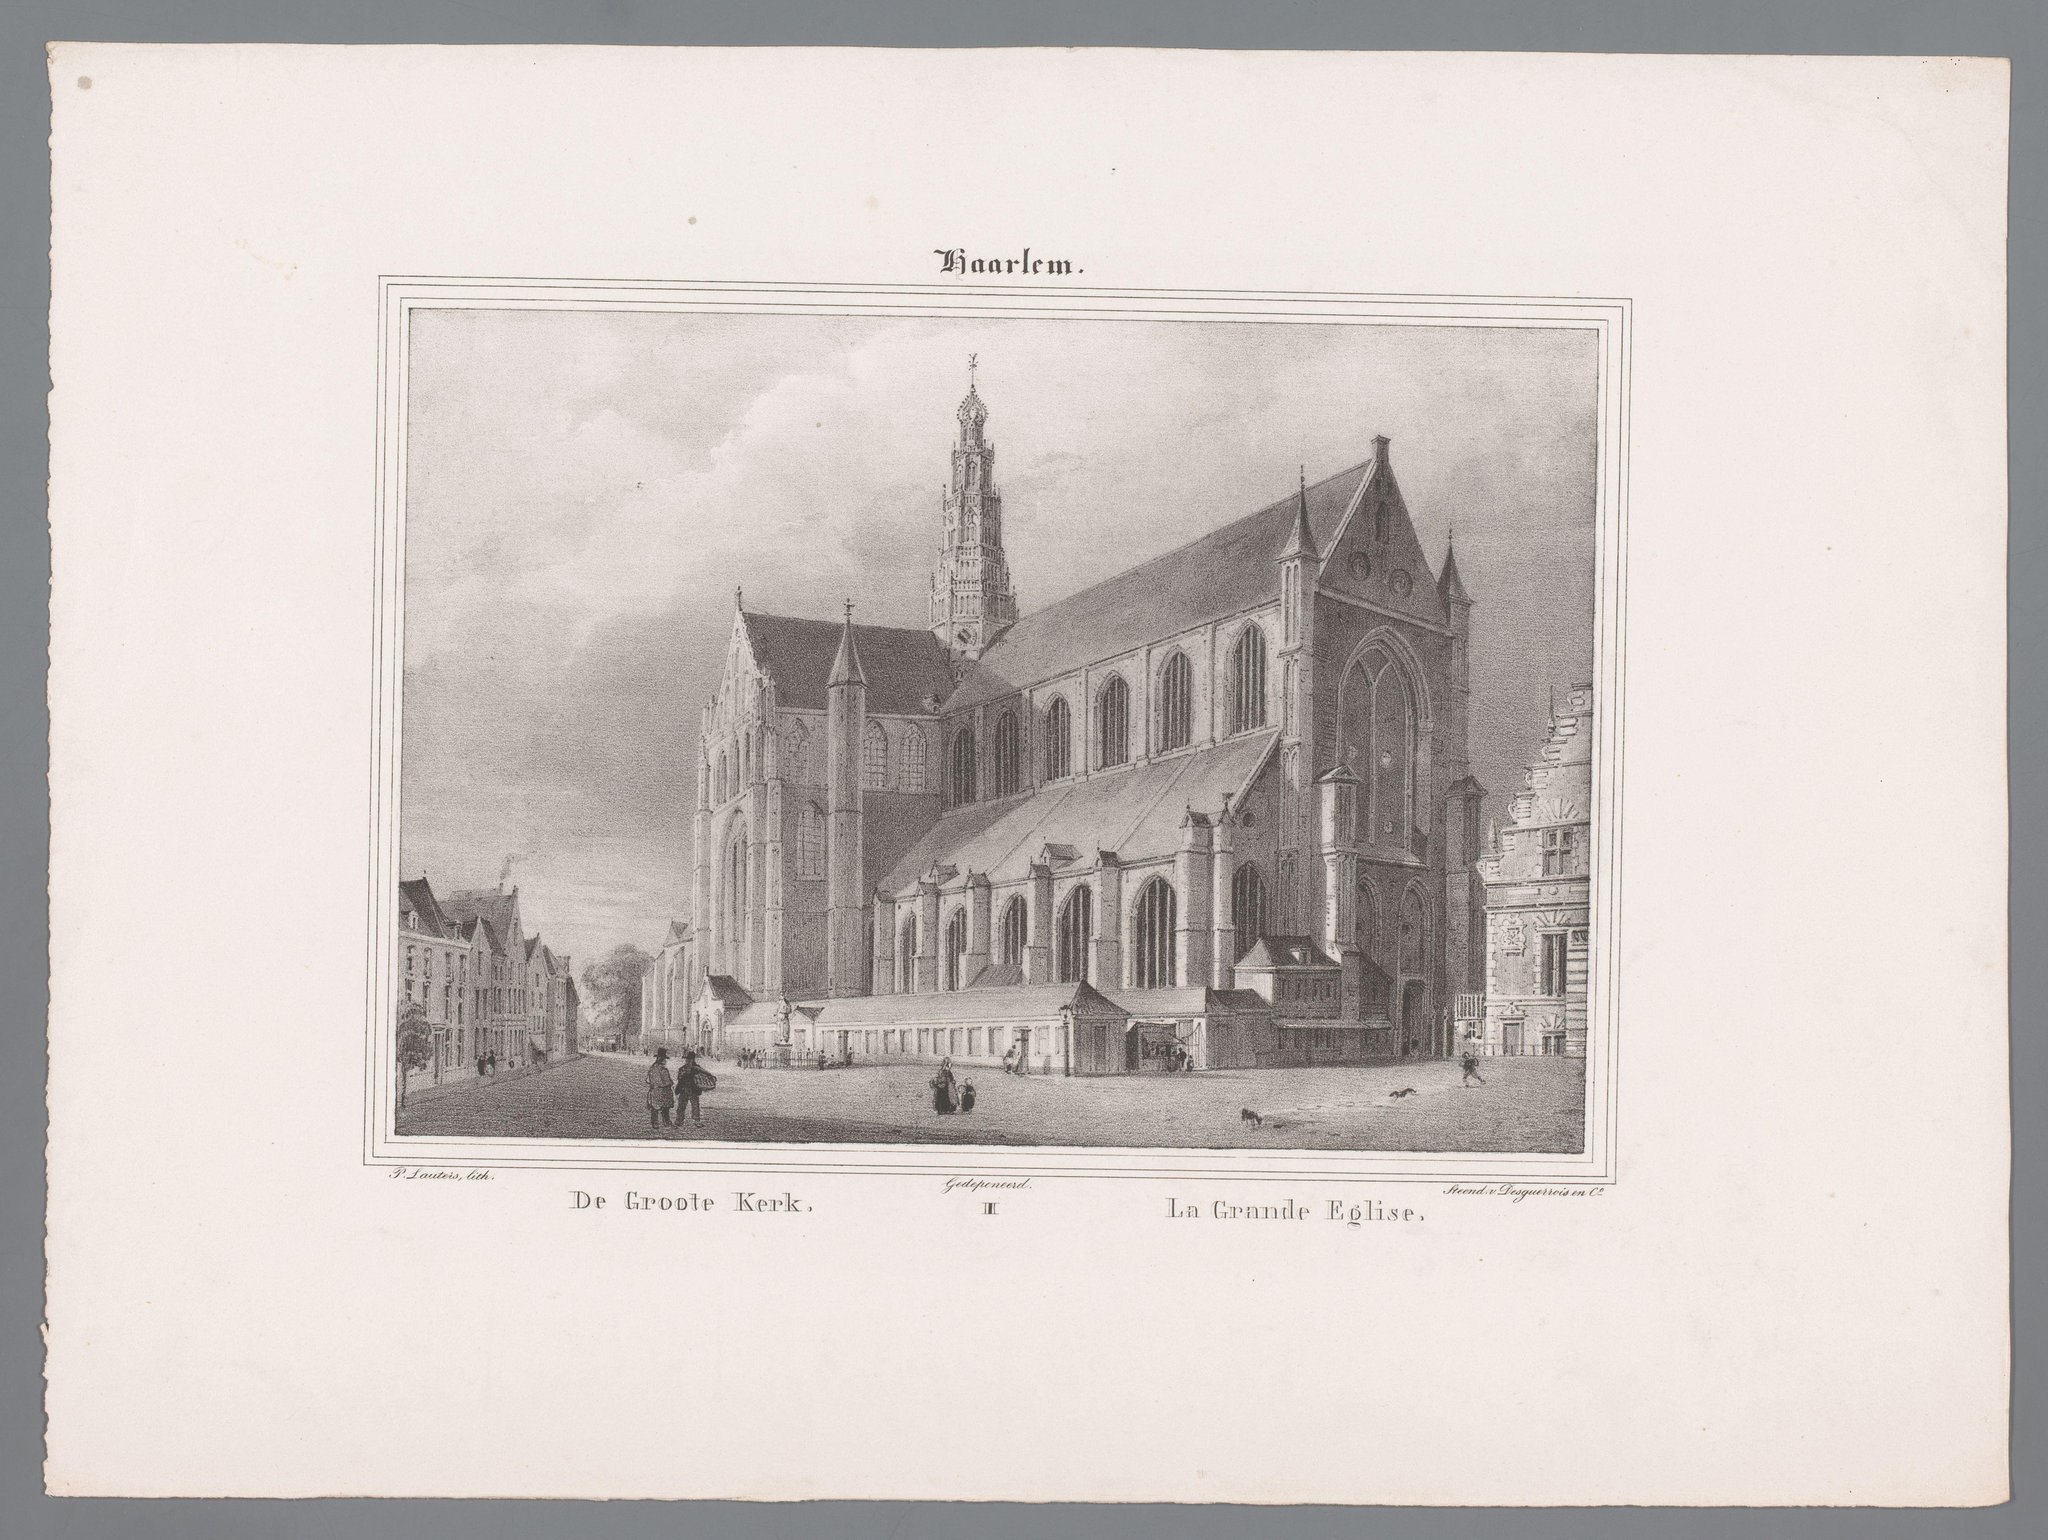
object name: print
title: Gezicht op de Sint-Bavokerk te Haarlem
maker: paulus lauters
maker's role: print maker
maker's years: 1806-1875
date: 1836-1840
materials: paper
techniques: lithograph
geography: amsterdam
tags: city-view in general; 'veduta'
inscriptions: collector's mark: Lugt 2228, : ‘Gedeponeerd.’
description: Prent maakt onderdeel uit van de serie: Hoofdgebouwen en gezichten der Voornaamste Steden van Holland. Onder deze naam werden in ieder geval verschillende stadgezichten gepubliceerd in de jaren 1836, 1839 en 1840 door Desguerrois & Co.